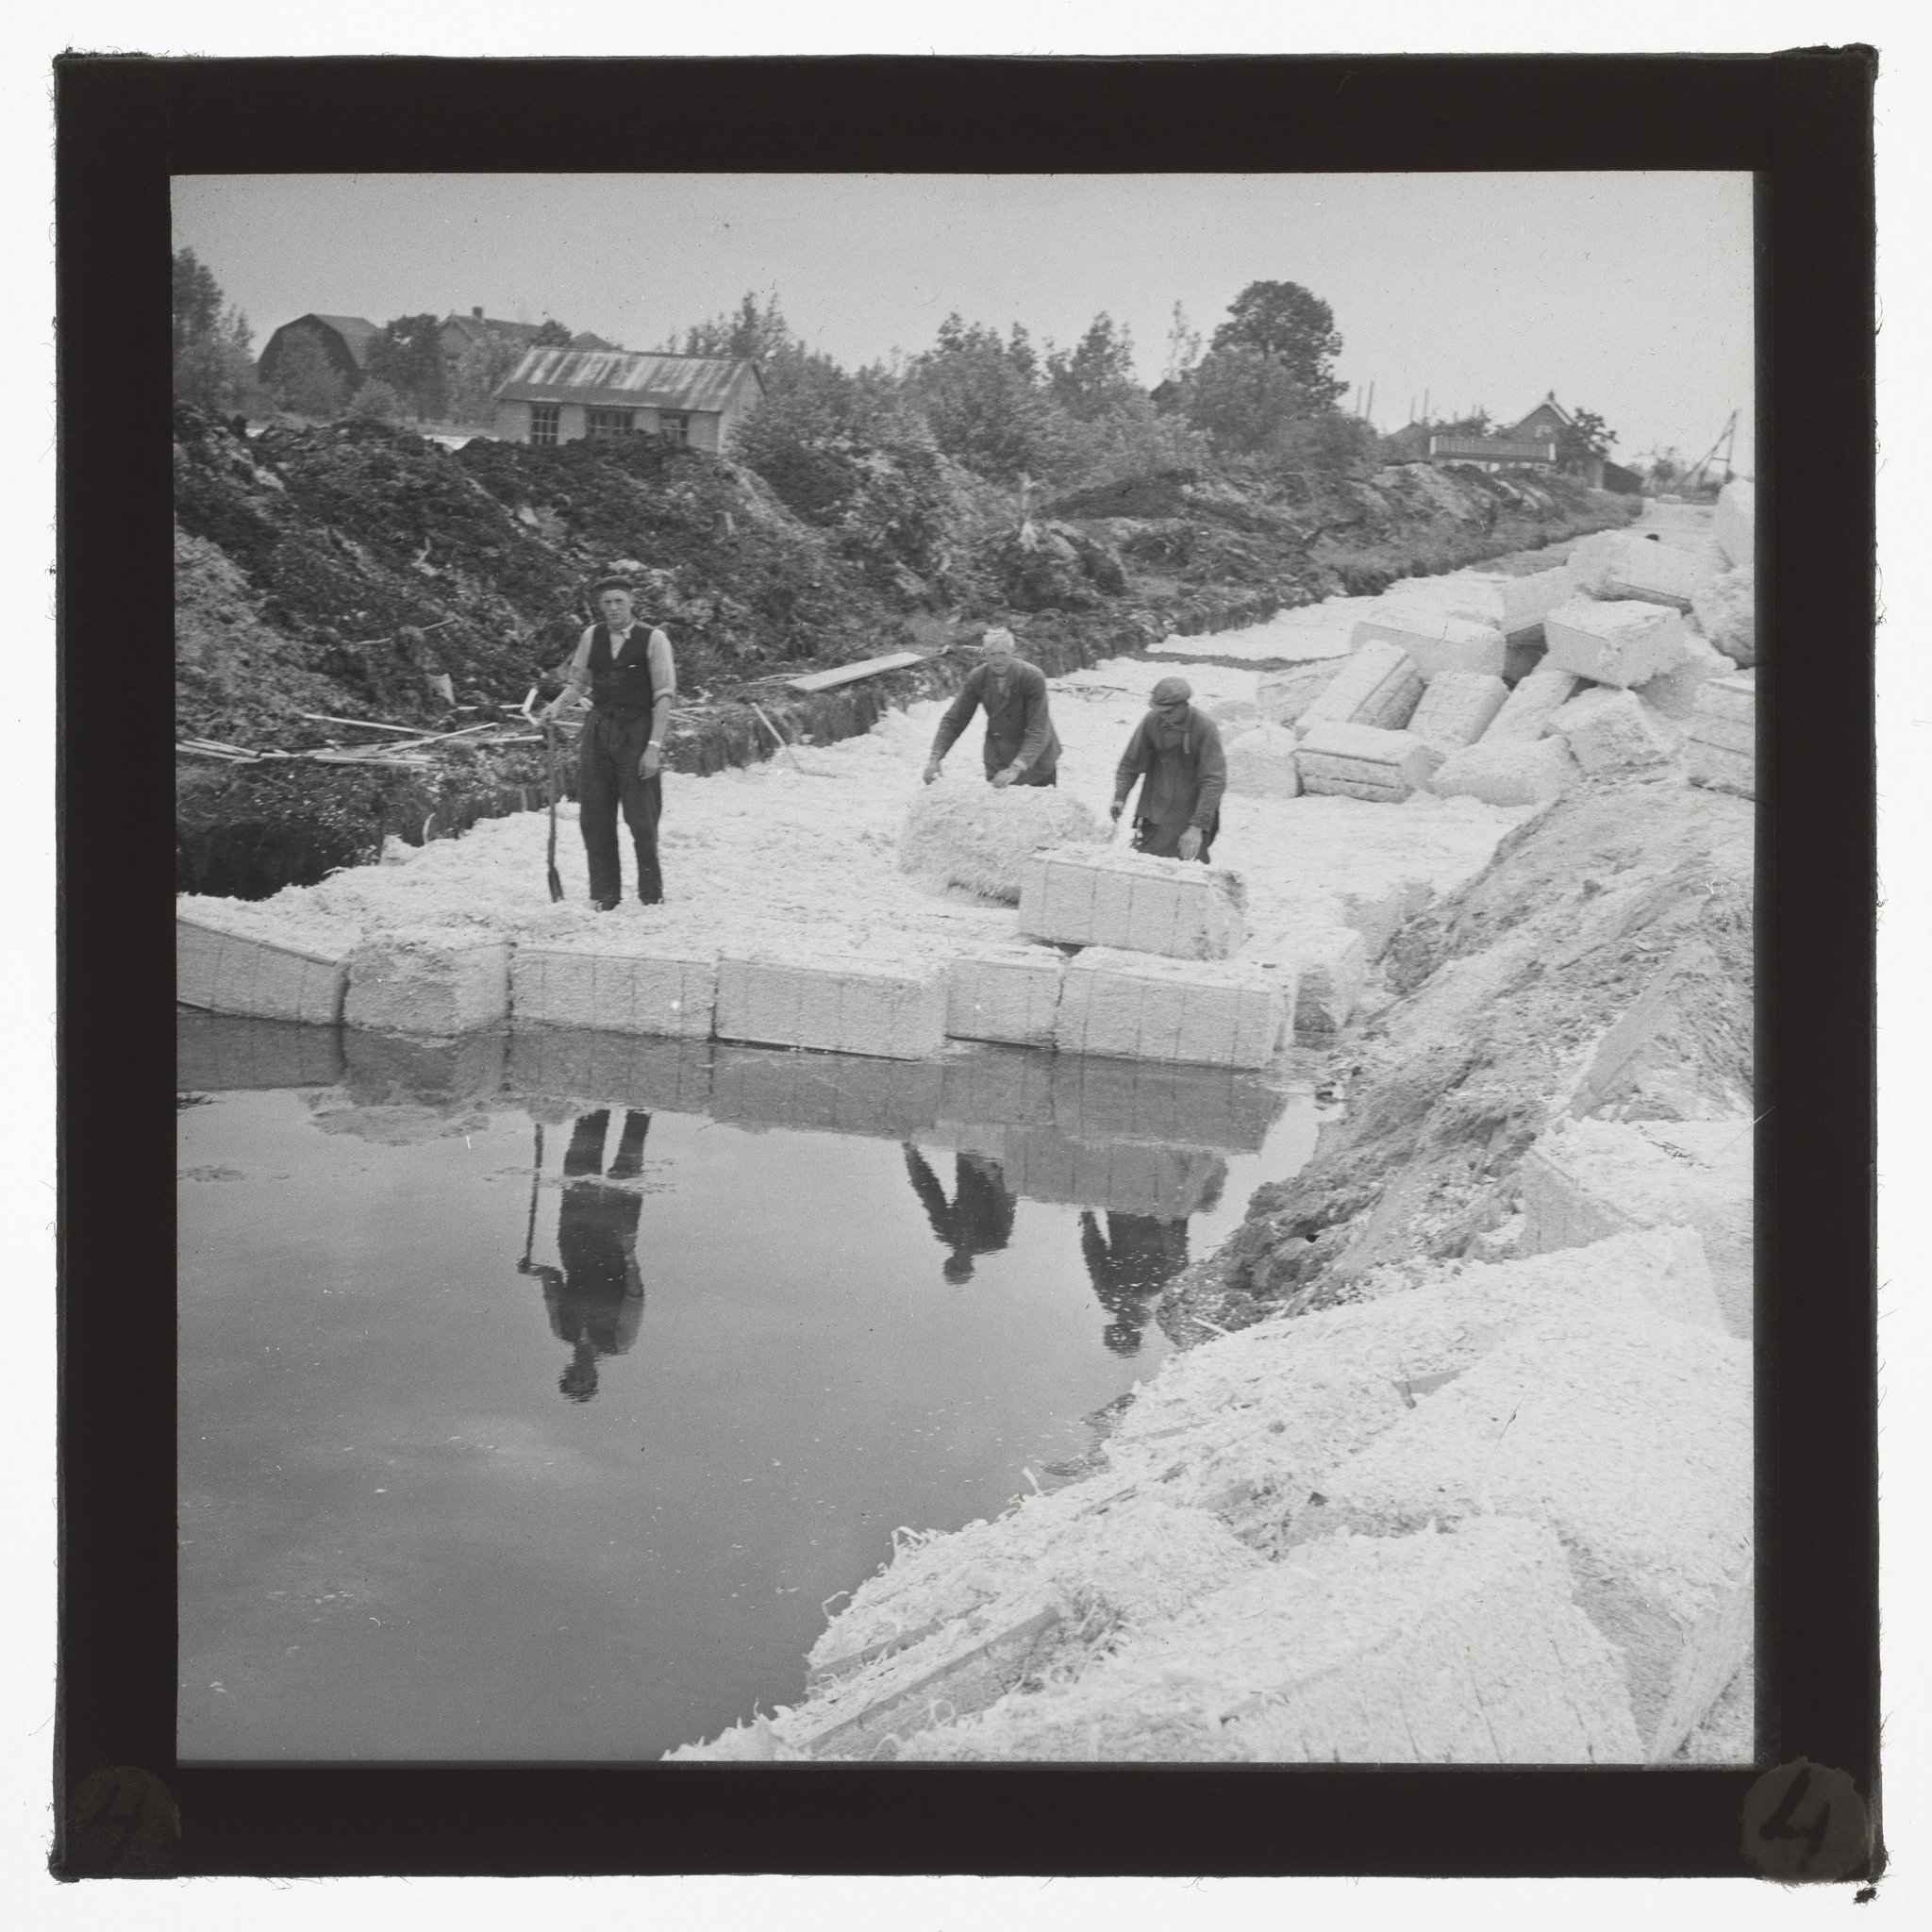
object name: lantern slide photographic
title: Mannen vormen een dam van balen hooi, Zuid-Holland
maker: Anonymous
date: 1956-1960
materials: glass, paper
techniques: gelatin silver transparency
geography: south holland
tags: agricultural products and by-products: hay, public road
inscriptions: number: ‘4’